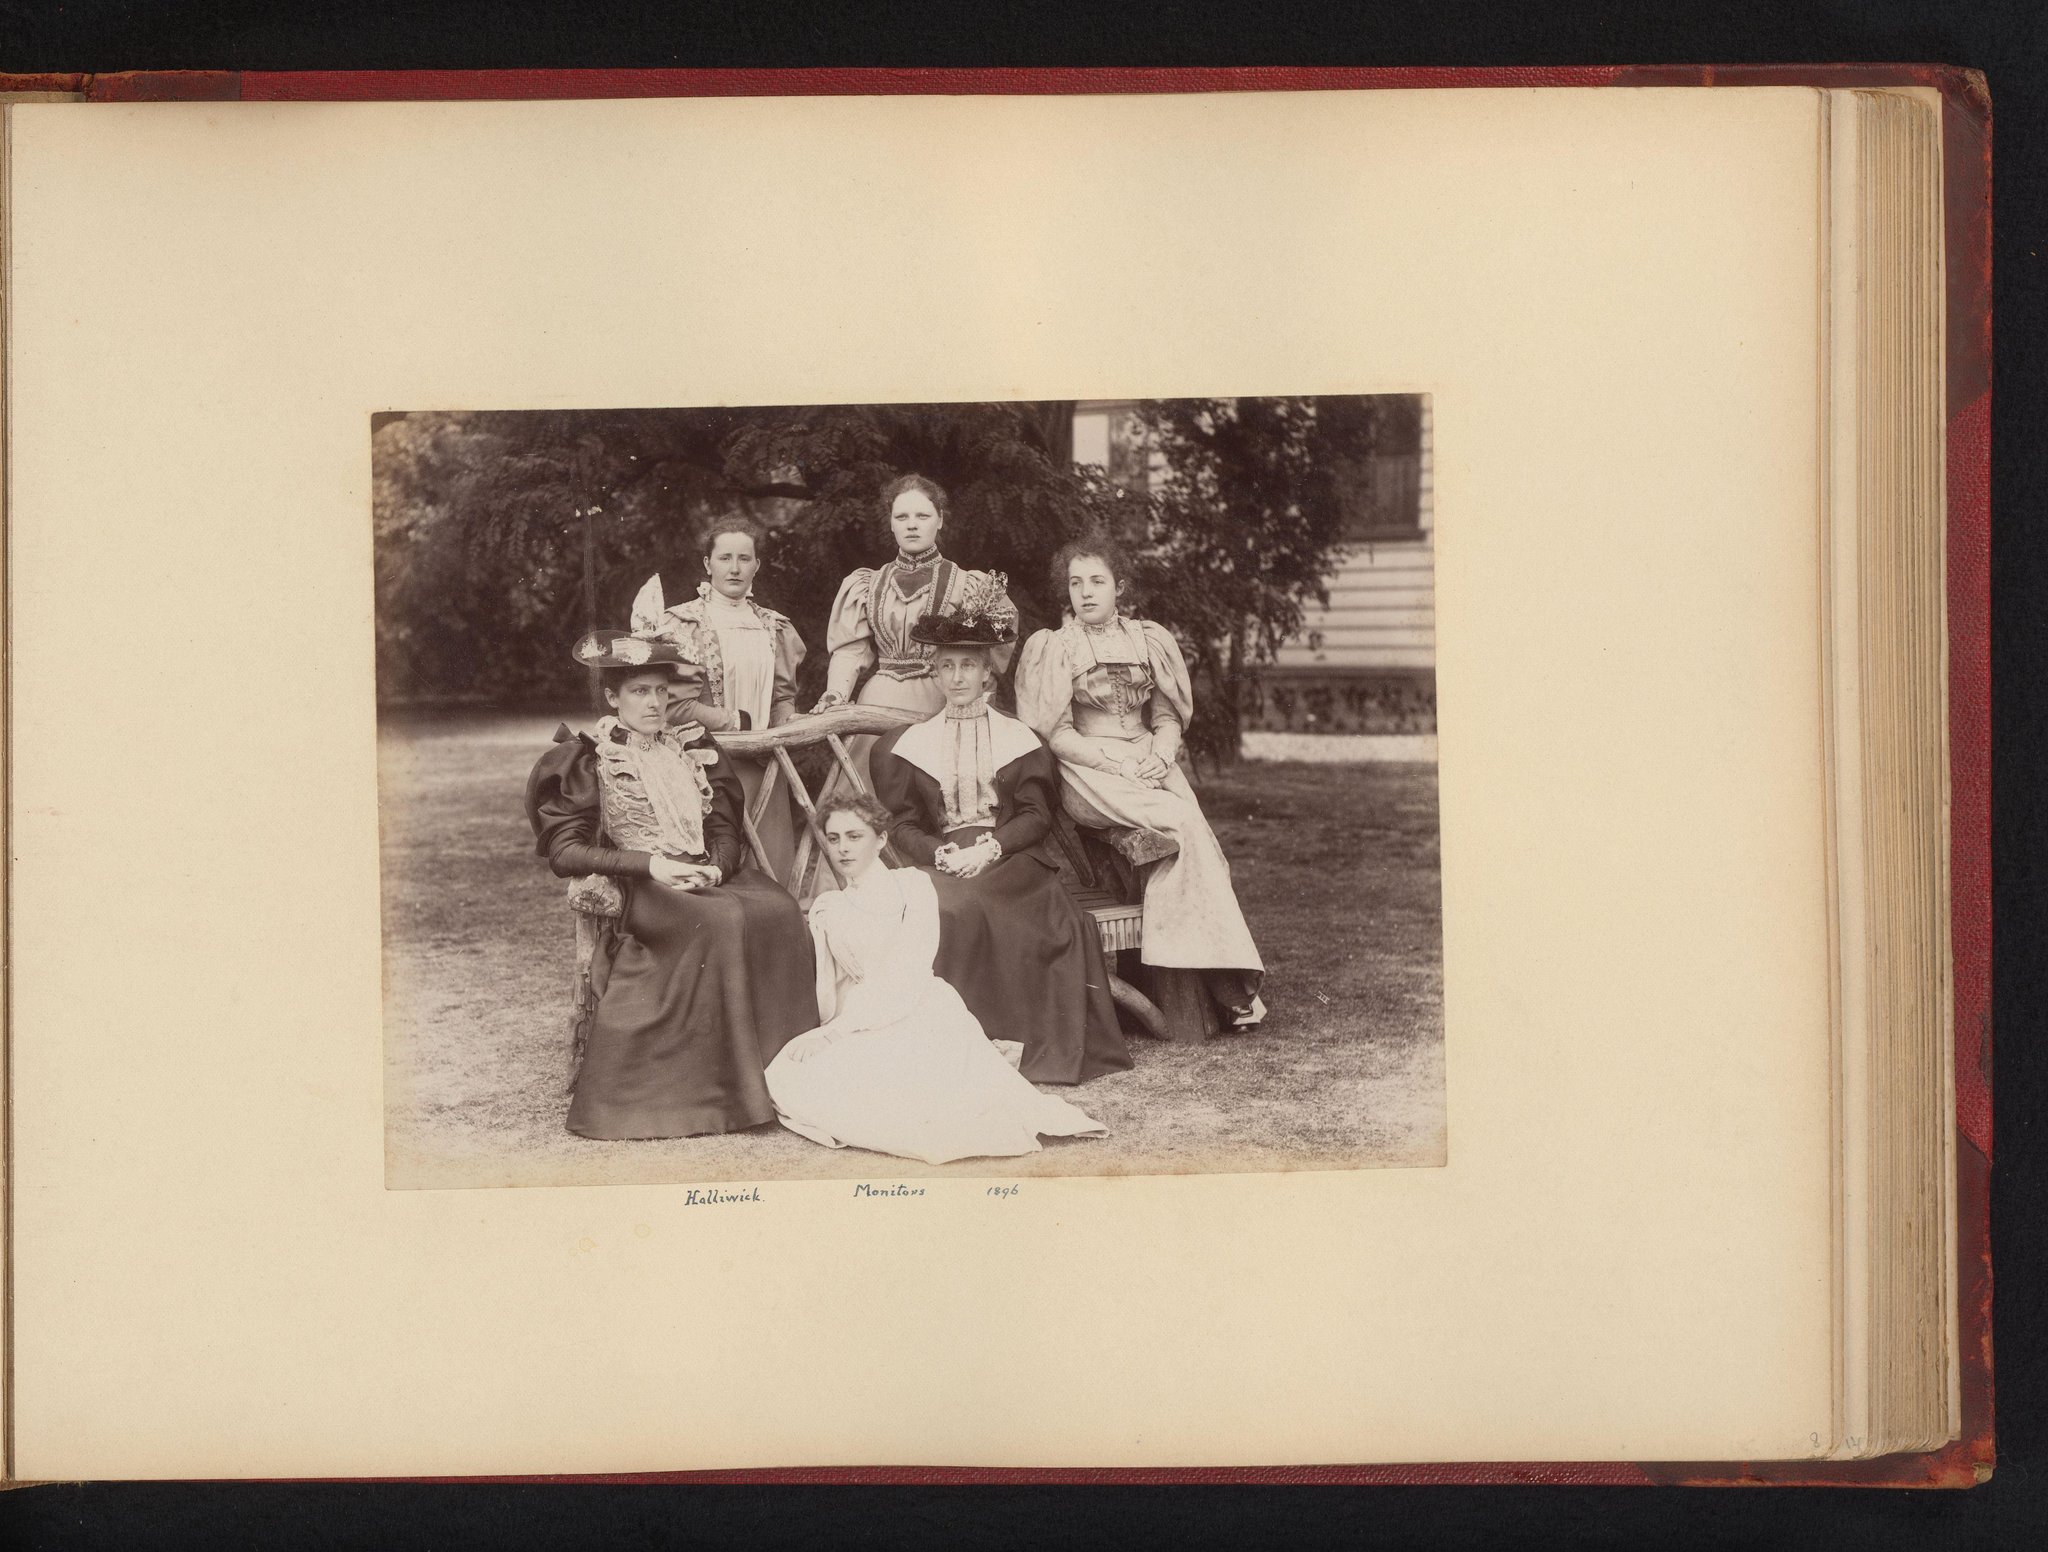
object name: photograph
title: Groepsportret met begeleiders van de Halliwick School for Girls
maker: Anonymous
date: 1896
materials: cardboard, photographic support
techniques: albumen print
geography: london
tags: anonymous historical persons portrayed in a group, in a group-portrait - bb - woman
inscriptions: annotation: ‘Halliwick. Monitors. 1896.’